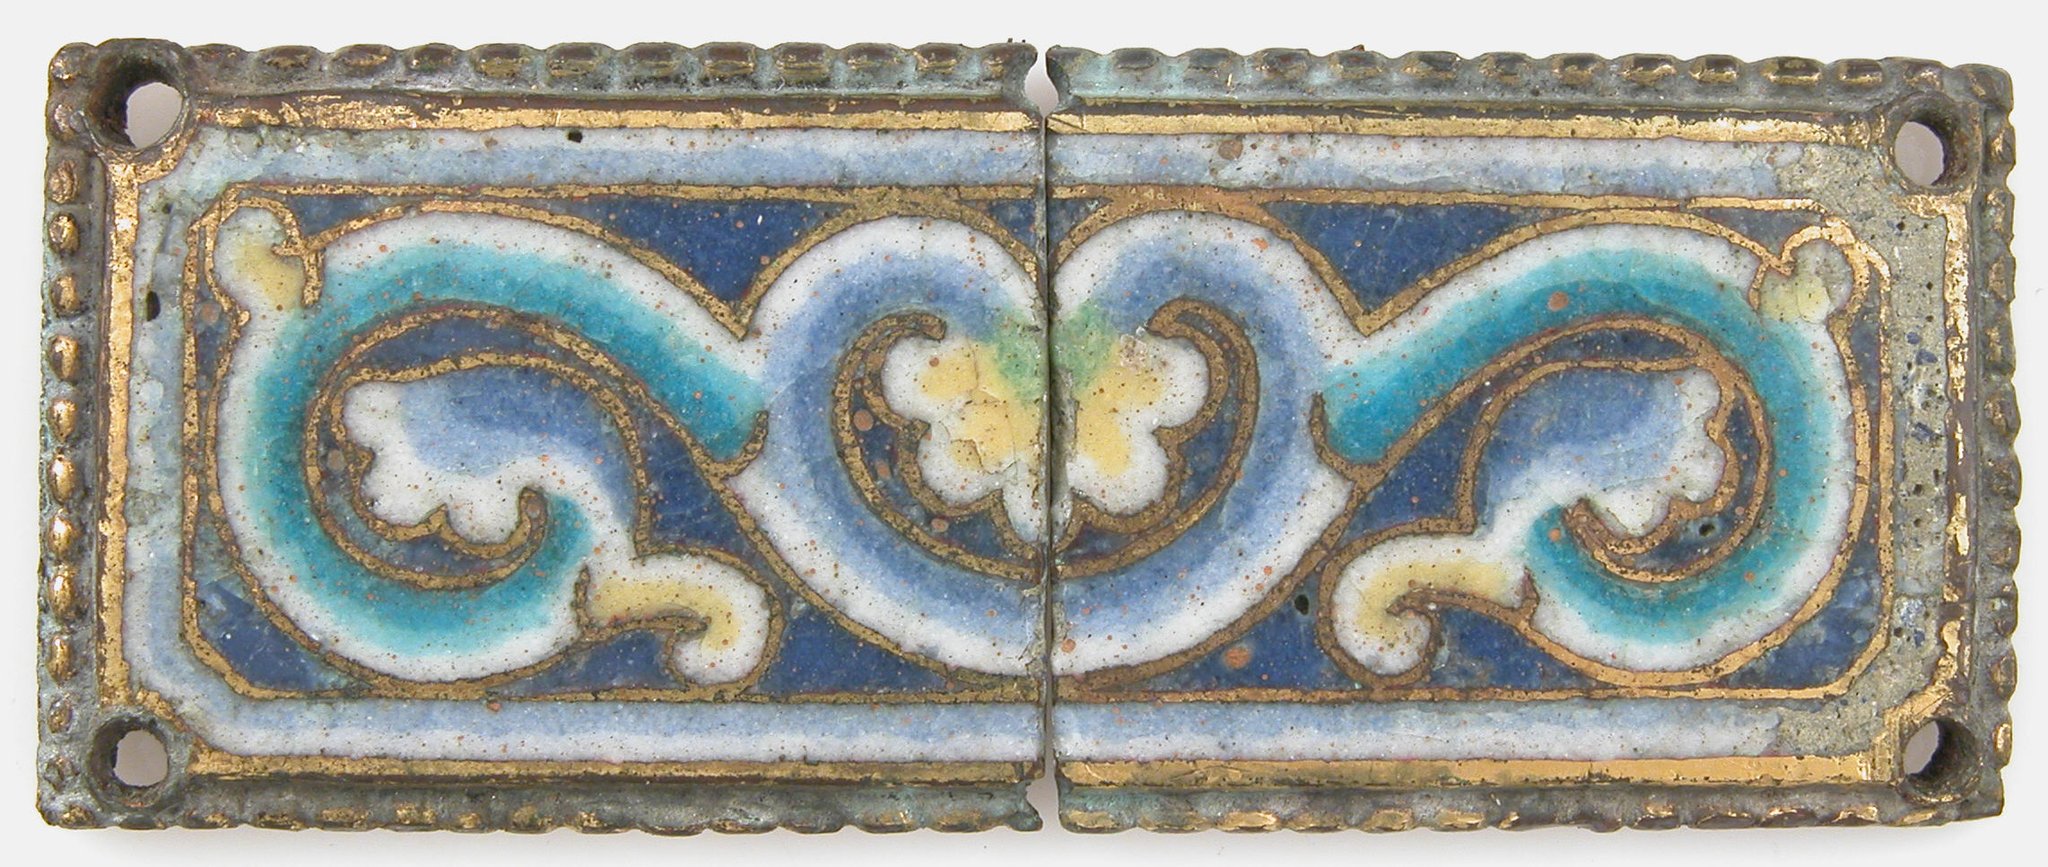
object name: plaque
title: Plaque from a Reliquary Shrine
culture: german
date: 1170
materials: copper alloy, enamel, gilt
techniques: enamel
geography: germany